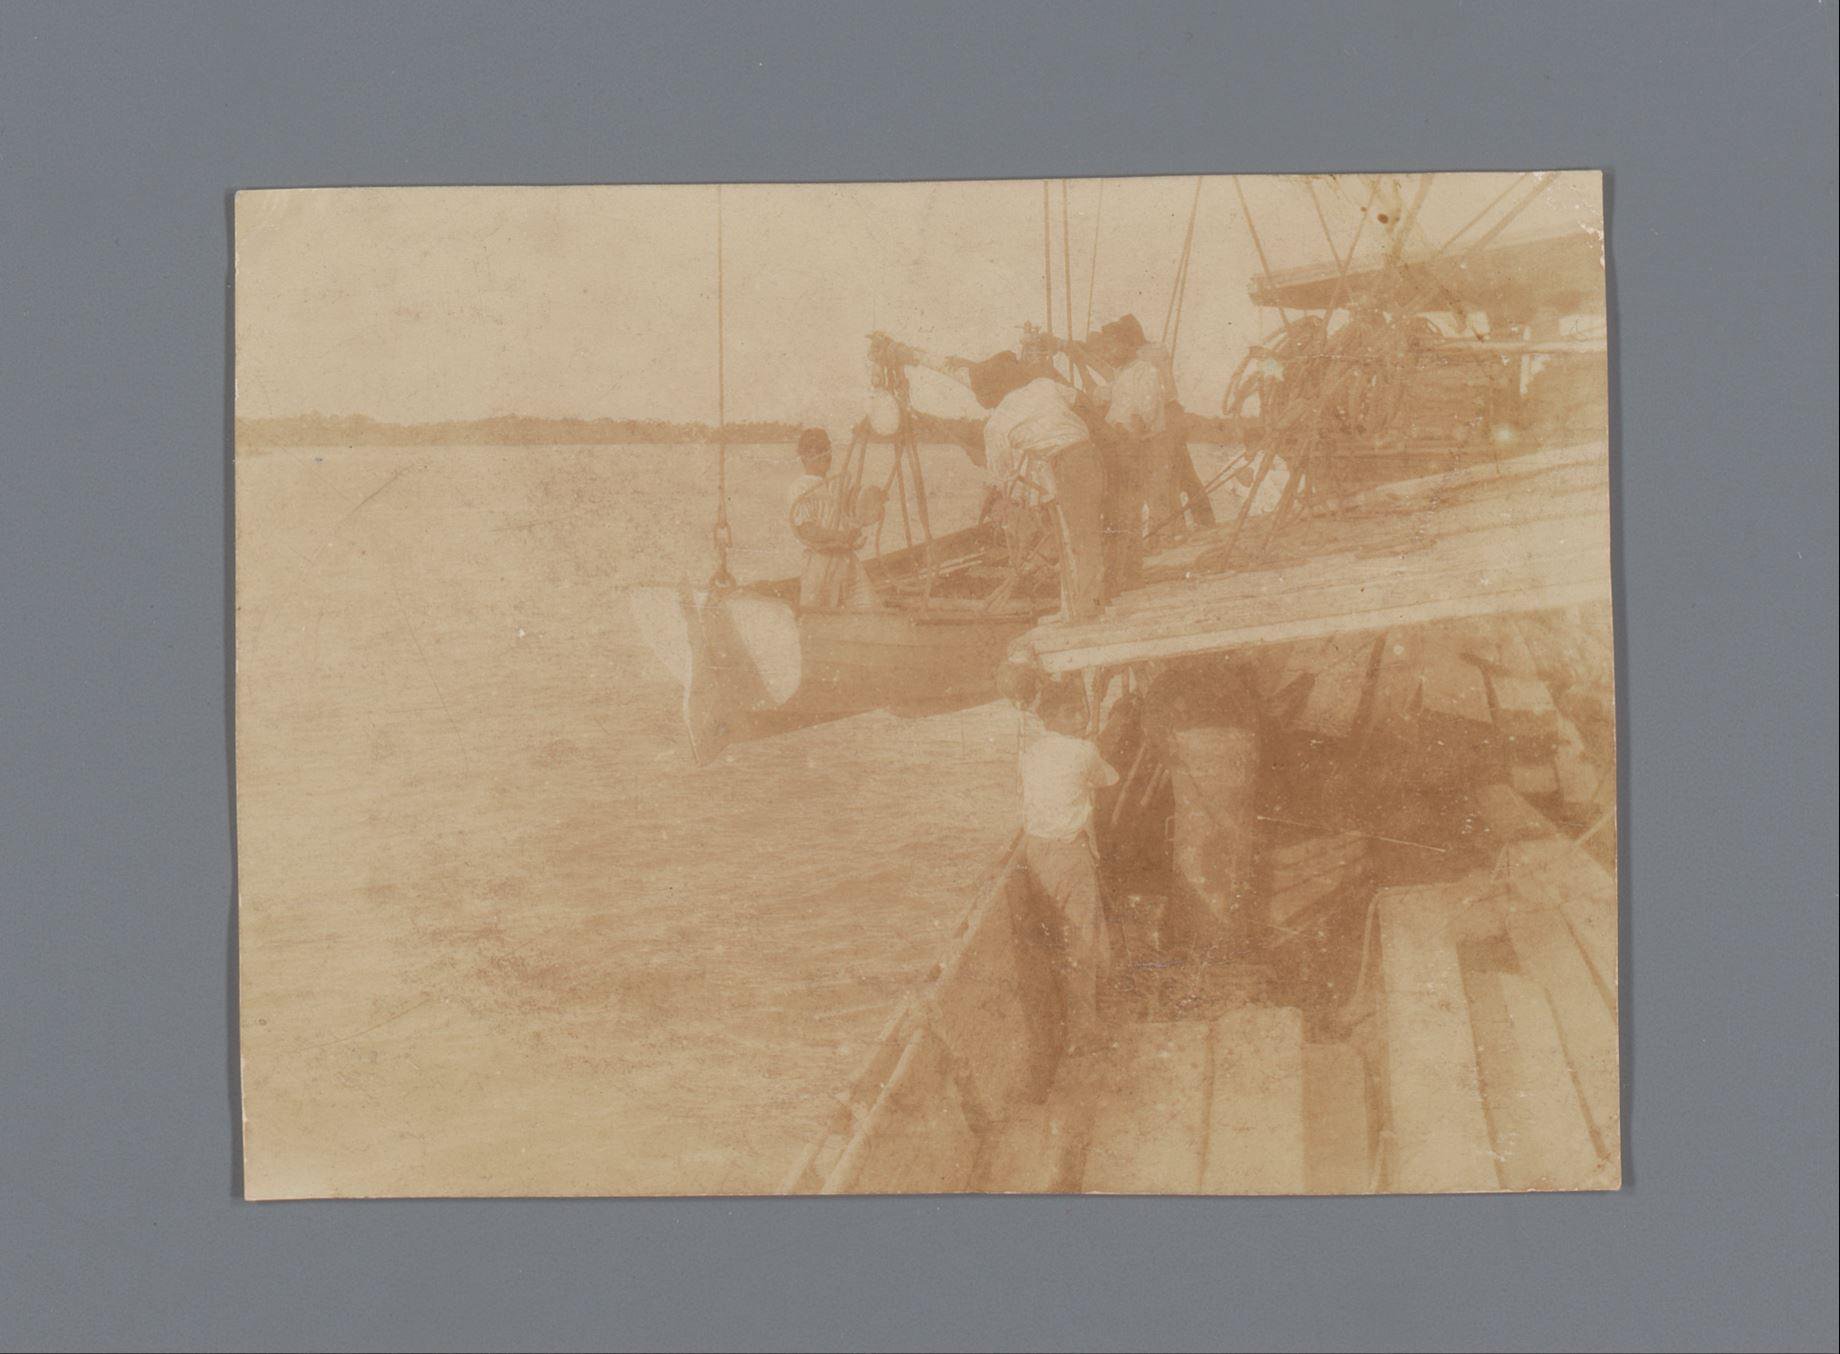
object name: photograph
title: Neerlaten van een sloep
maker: Anonymous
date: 1930-1939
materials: photographic support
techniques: photography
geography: dutch east indies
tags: rowing-boat, canoe, etc., dutch east indies, the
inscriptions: annotation: ‘Met neelaten van een sloep. Op de van Veek’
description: Neerlaten van een sloep van een andere boot. Vijf Indiërs. Op achtergrond land in zicht. Afkomstig uit het losbladig fotoalbum 'Fraters van Tilburg op Celebes en Sumatra'.